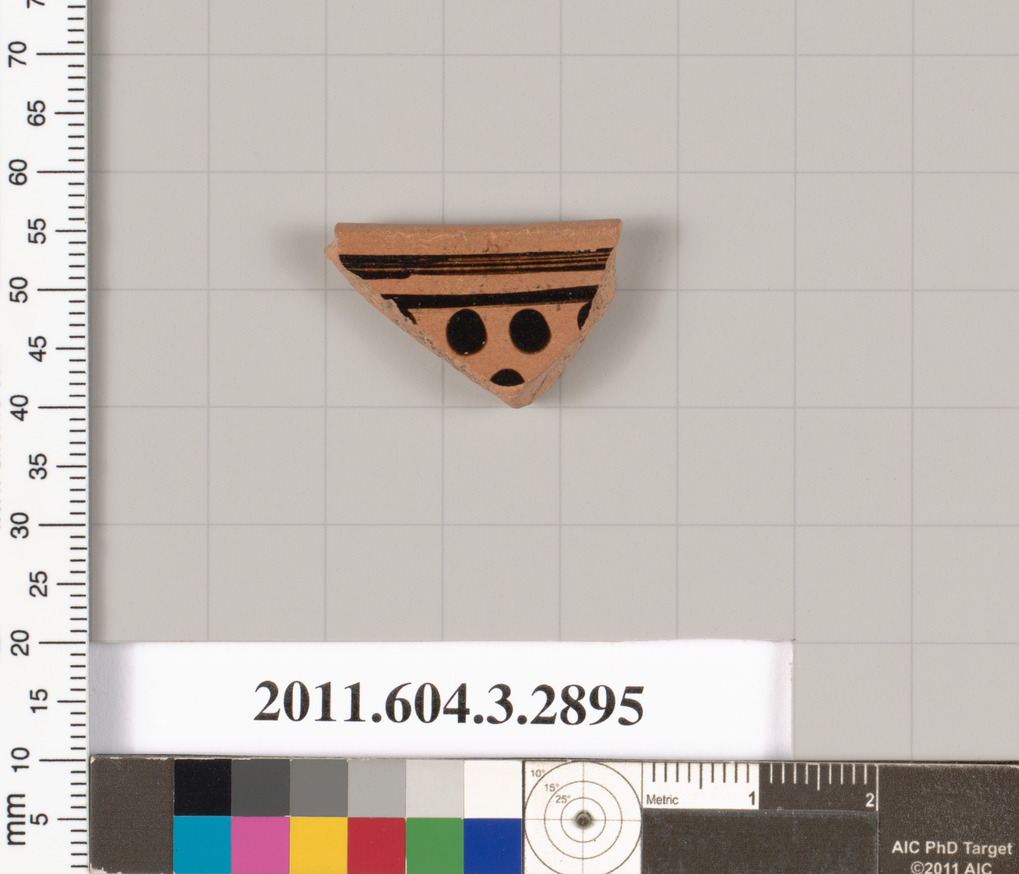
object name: undetermined shape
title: Terracotta fragment of an undetermined shape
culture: greek, attic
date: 534-468 BCE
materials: terracotta